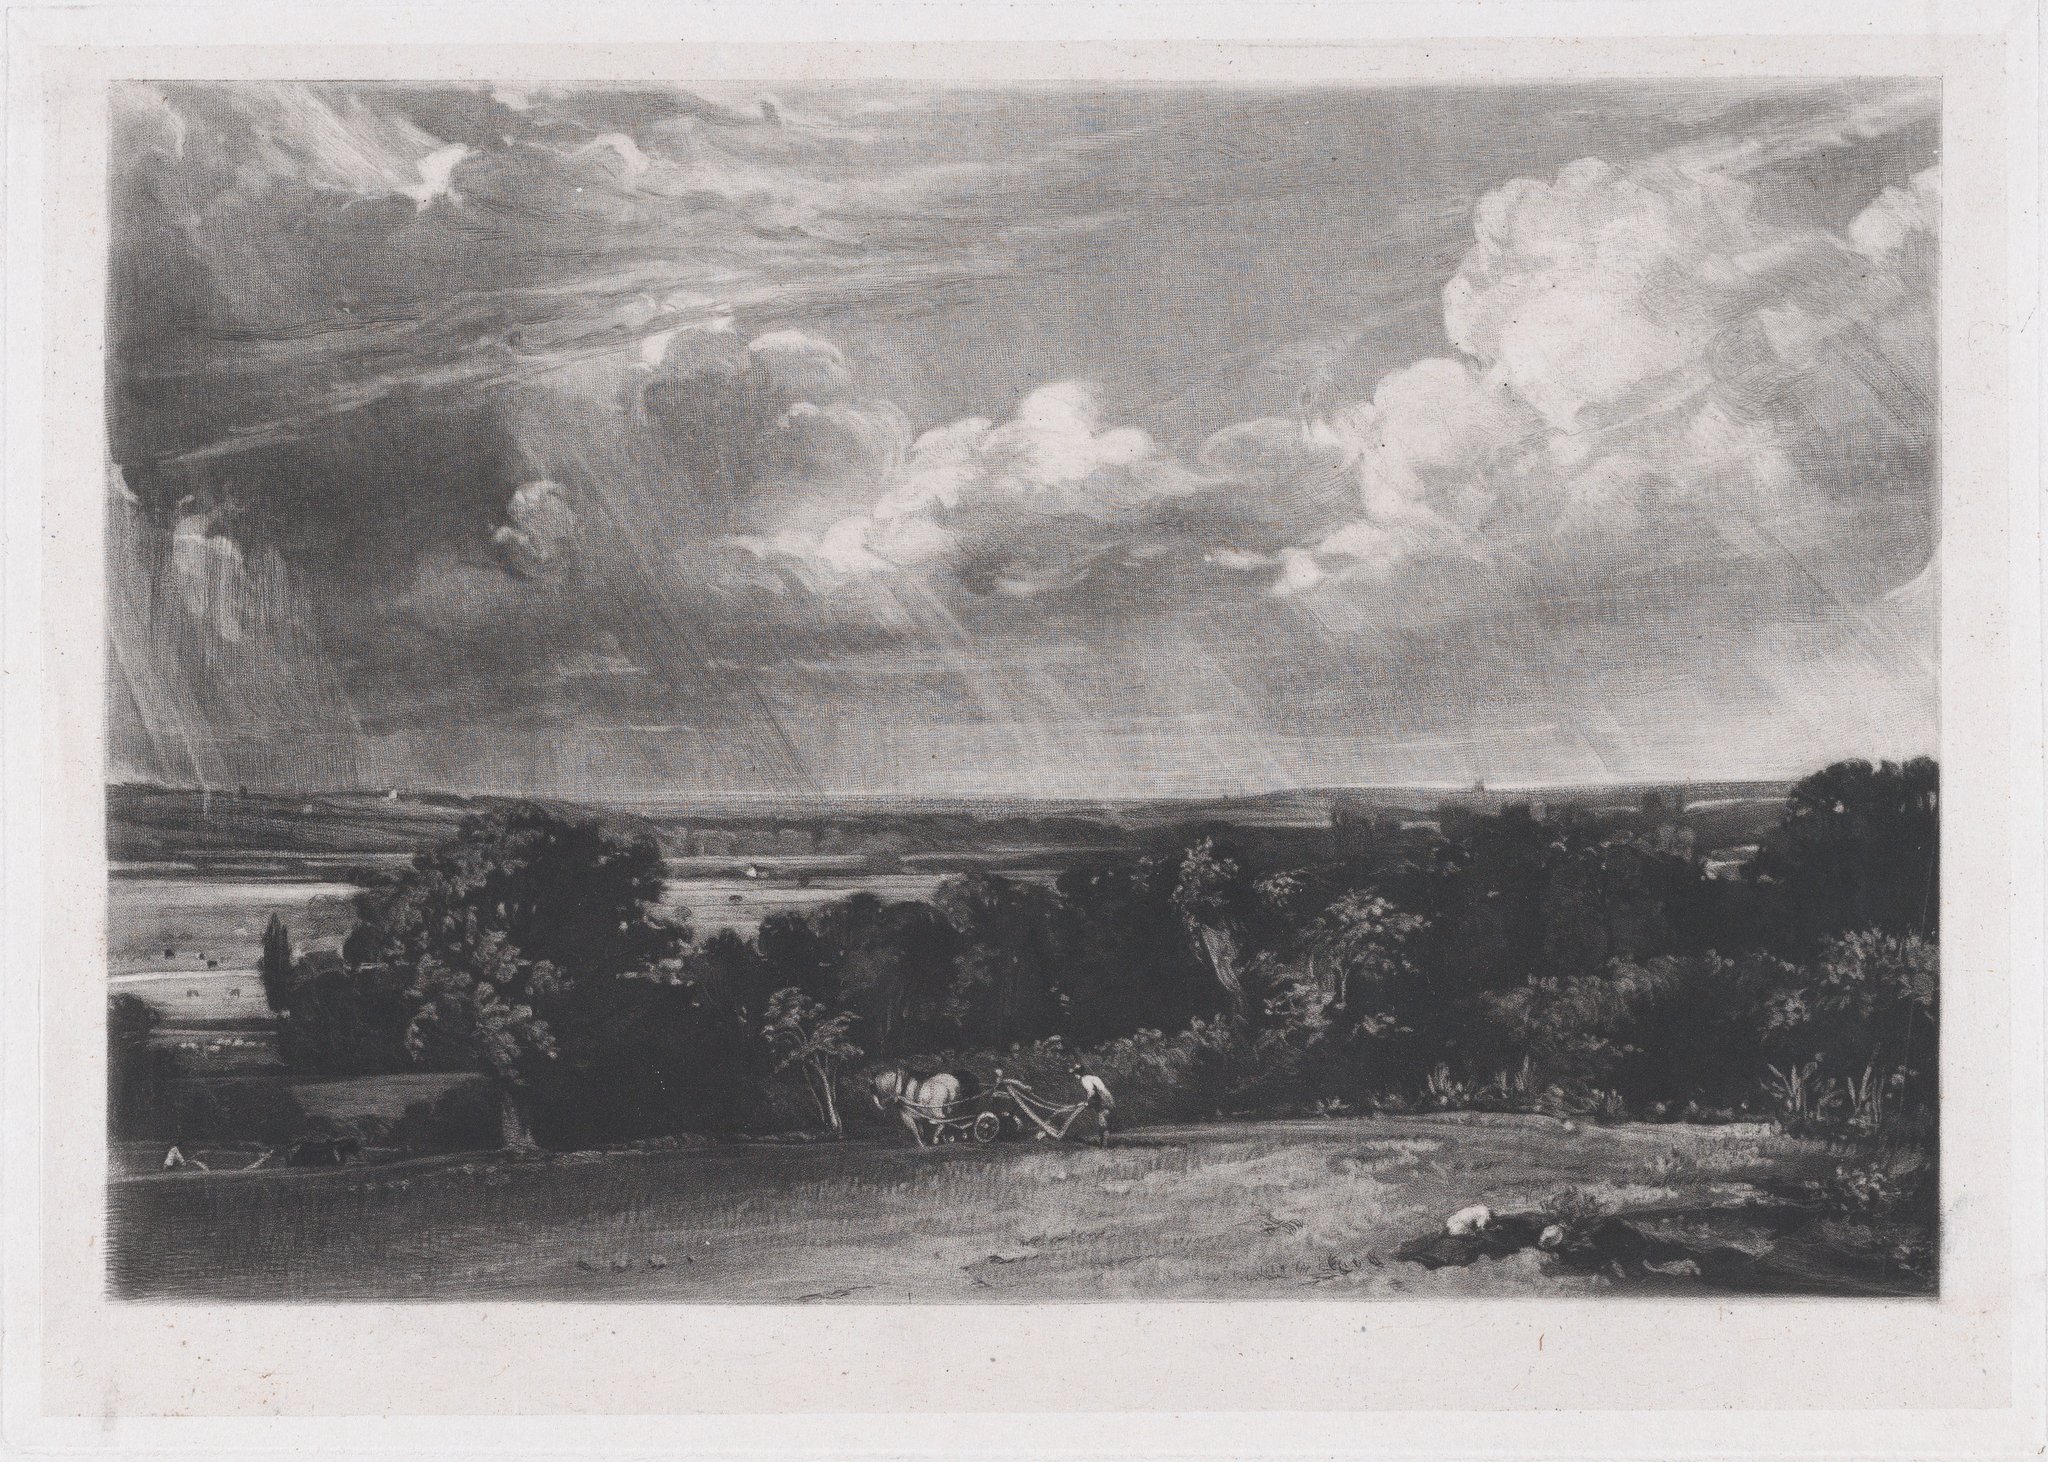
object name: print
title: A Summerland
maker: david lucas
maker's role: artist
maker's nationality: british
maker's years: 1802-1881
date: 1829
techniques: printmaking, mezzotint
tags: farms,horses,landscapes,clouds